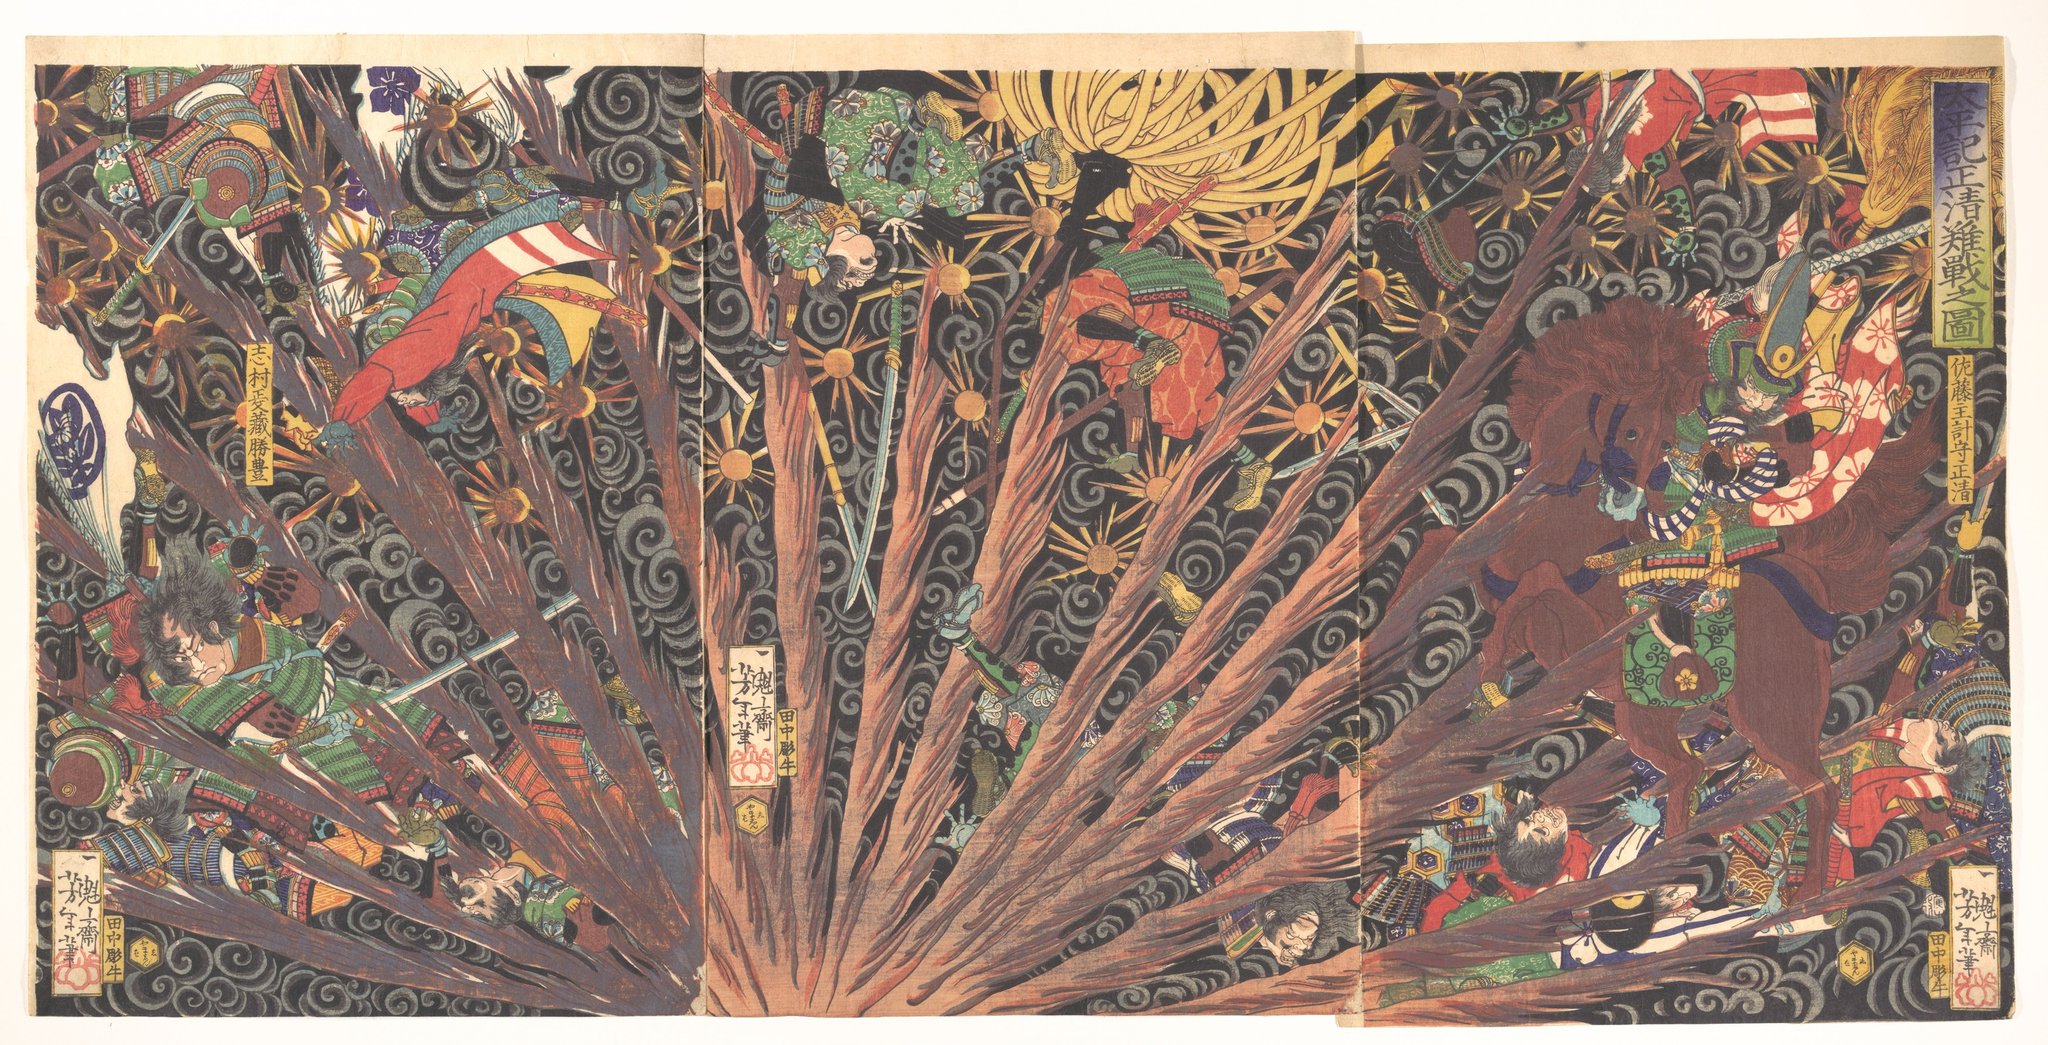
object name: print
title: Masakiyo’s Challenging Battle, from Taiheiki (Chronicle of great peace)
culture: japanese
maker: tsukioka yoshitoshi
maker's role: artist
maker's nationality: japanese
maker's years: 1839-1892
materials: ink, paper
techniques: nishiki e, woodblock print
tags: battles,weapons,men,horses